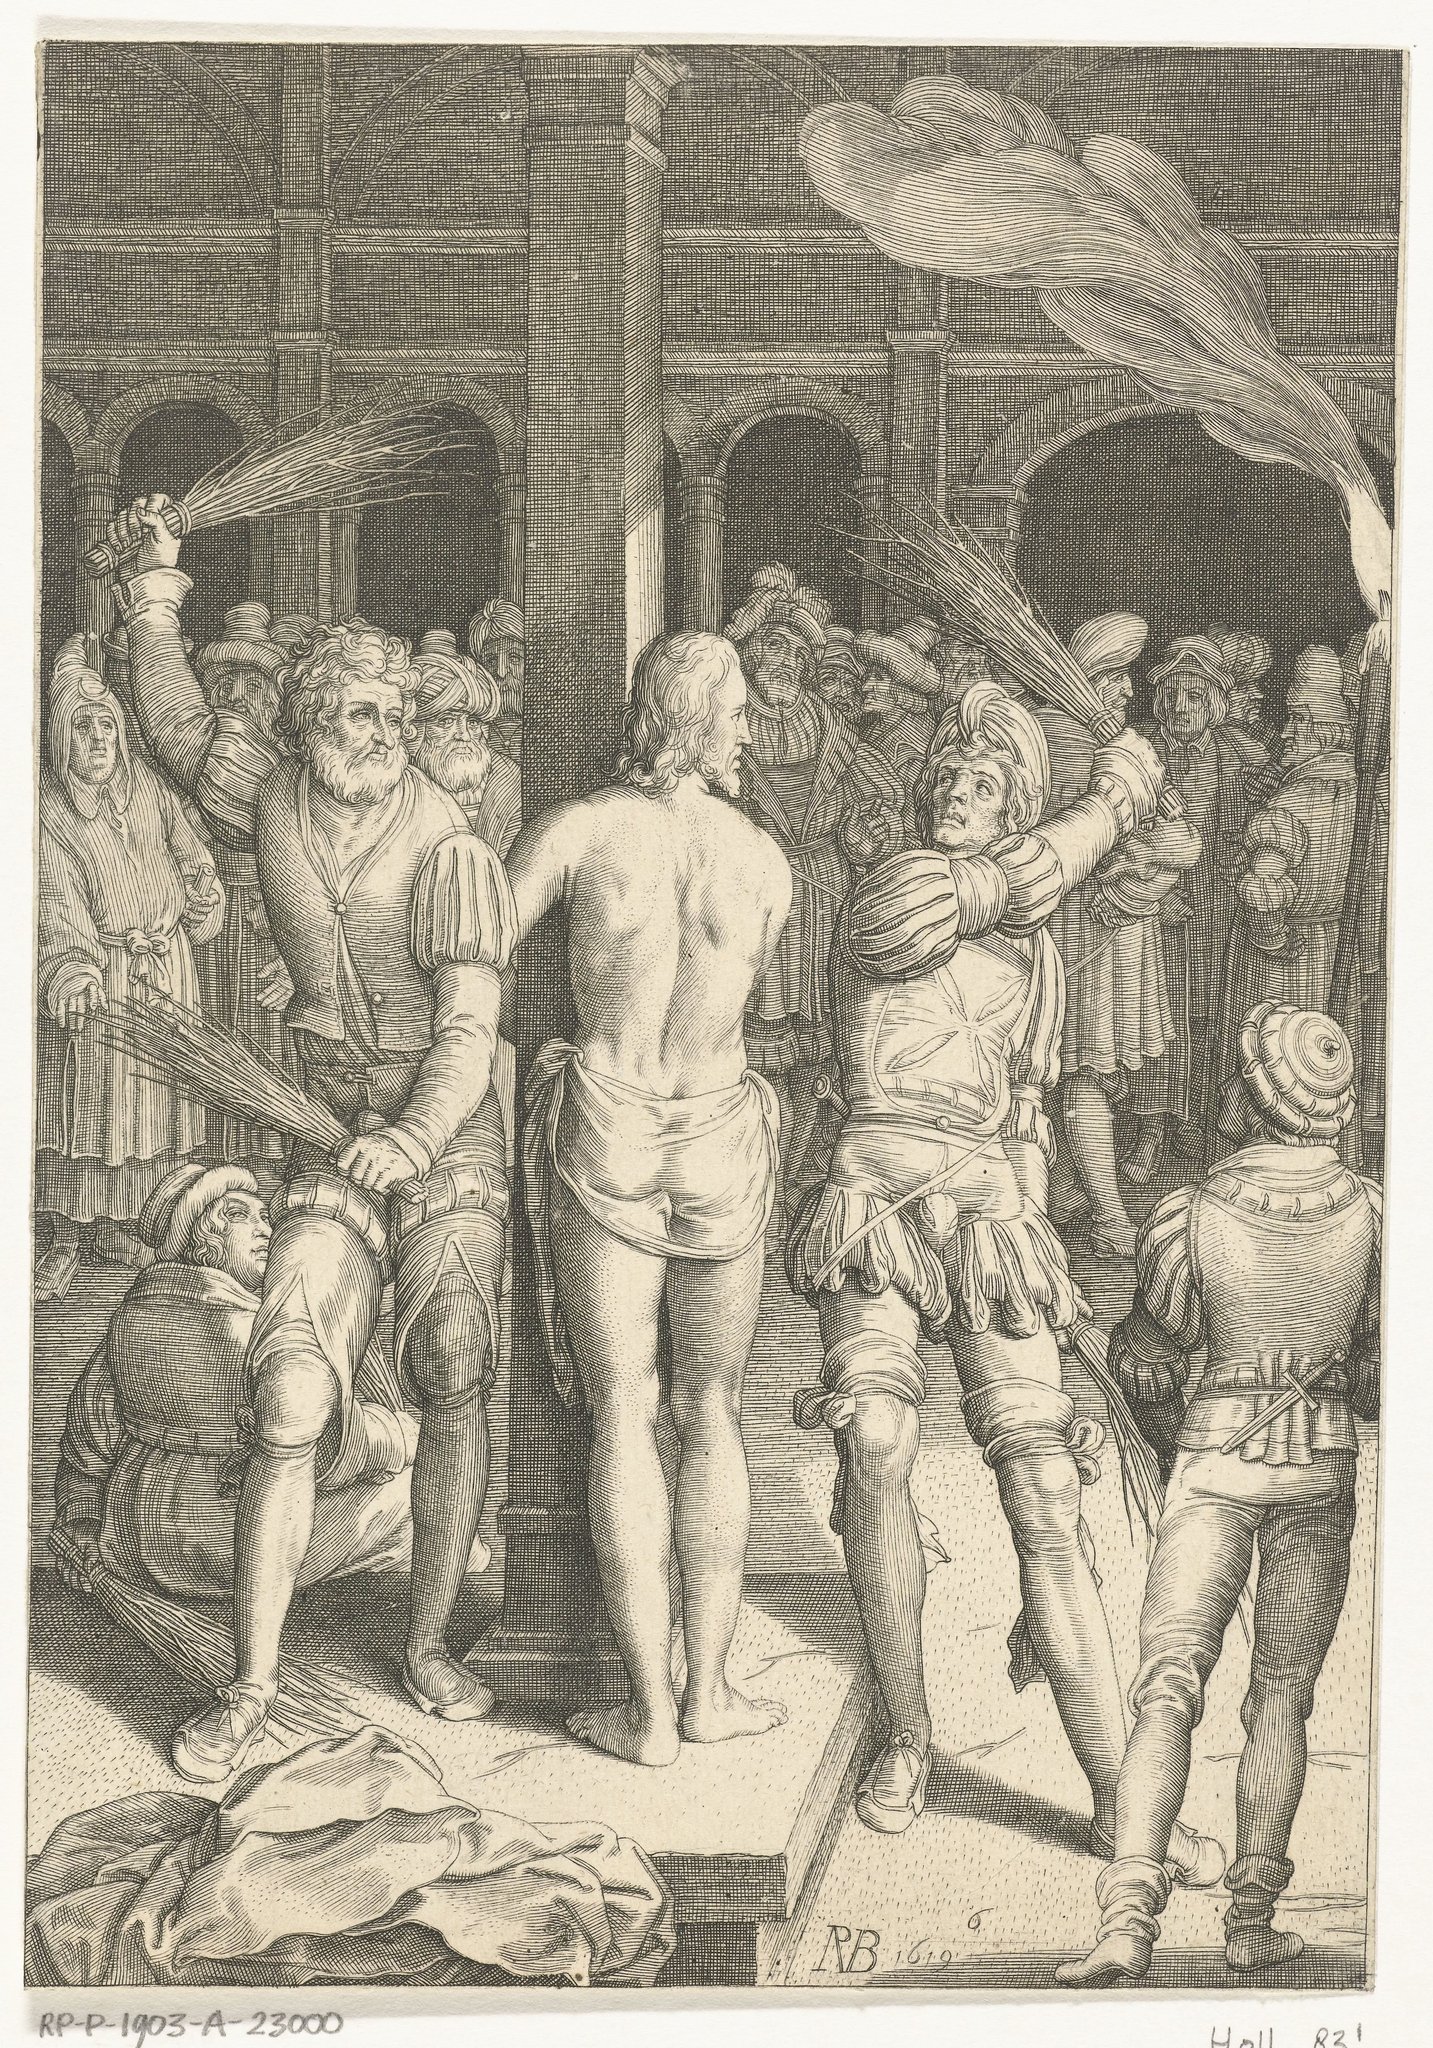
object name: print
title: Geseling van Christus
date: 1619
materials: paper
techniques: engraving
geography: netherlands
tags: flagellation by soldiers, christ usually tied to a column (matthew 27:26; mark 15:15; john 19:1)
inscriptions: collector's mark: Lugt 567, collector's mark: Lugt 2228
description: Prent uit serie van twaalf prenten met scènes uit de Passie. Reeks geïnspireerd door de prenten van Hendrick Goltzius en Lucas van Leyden.